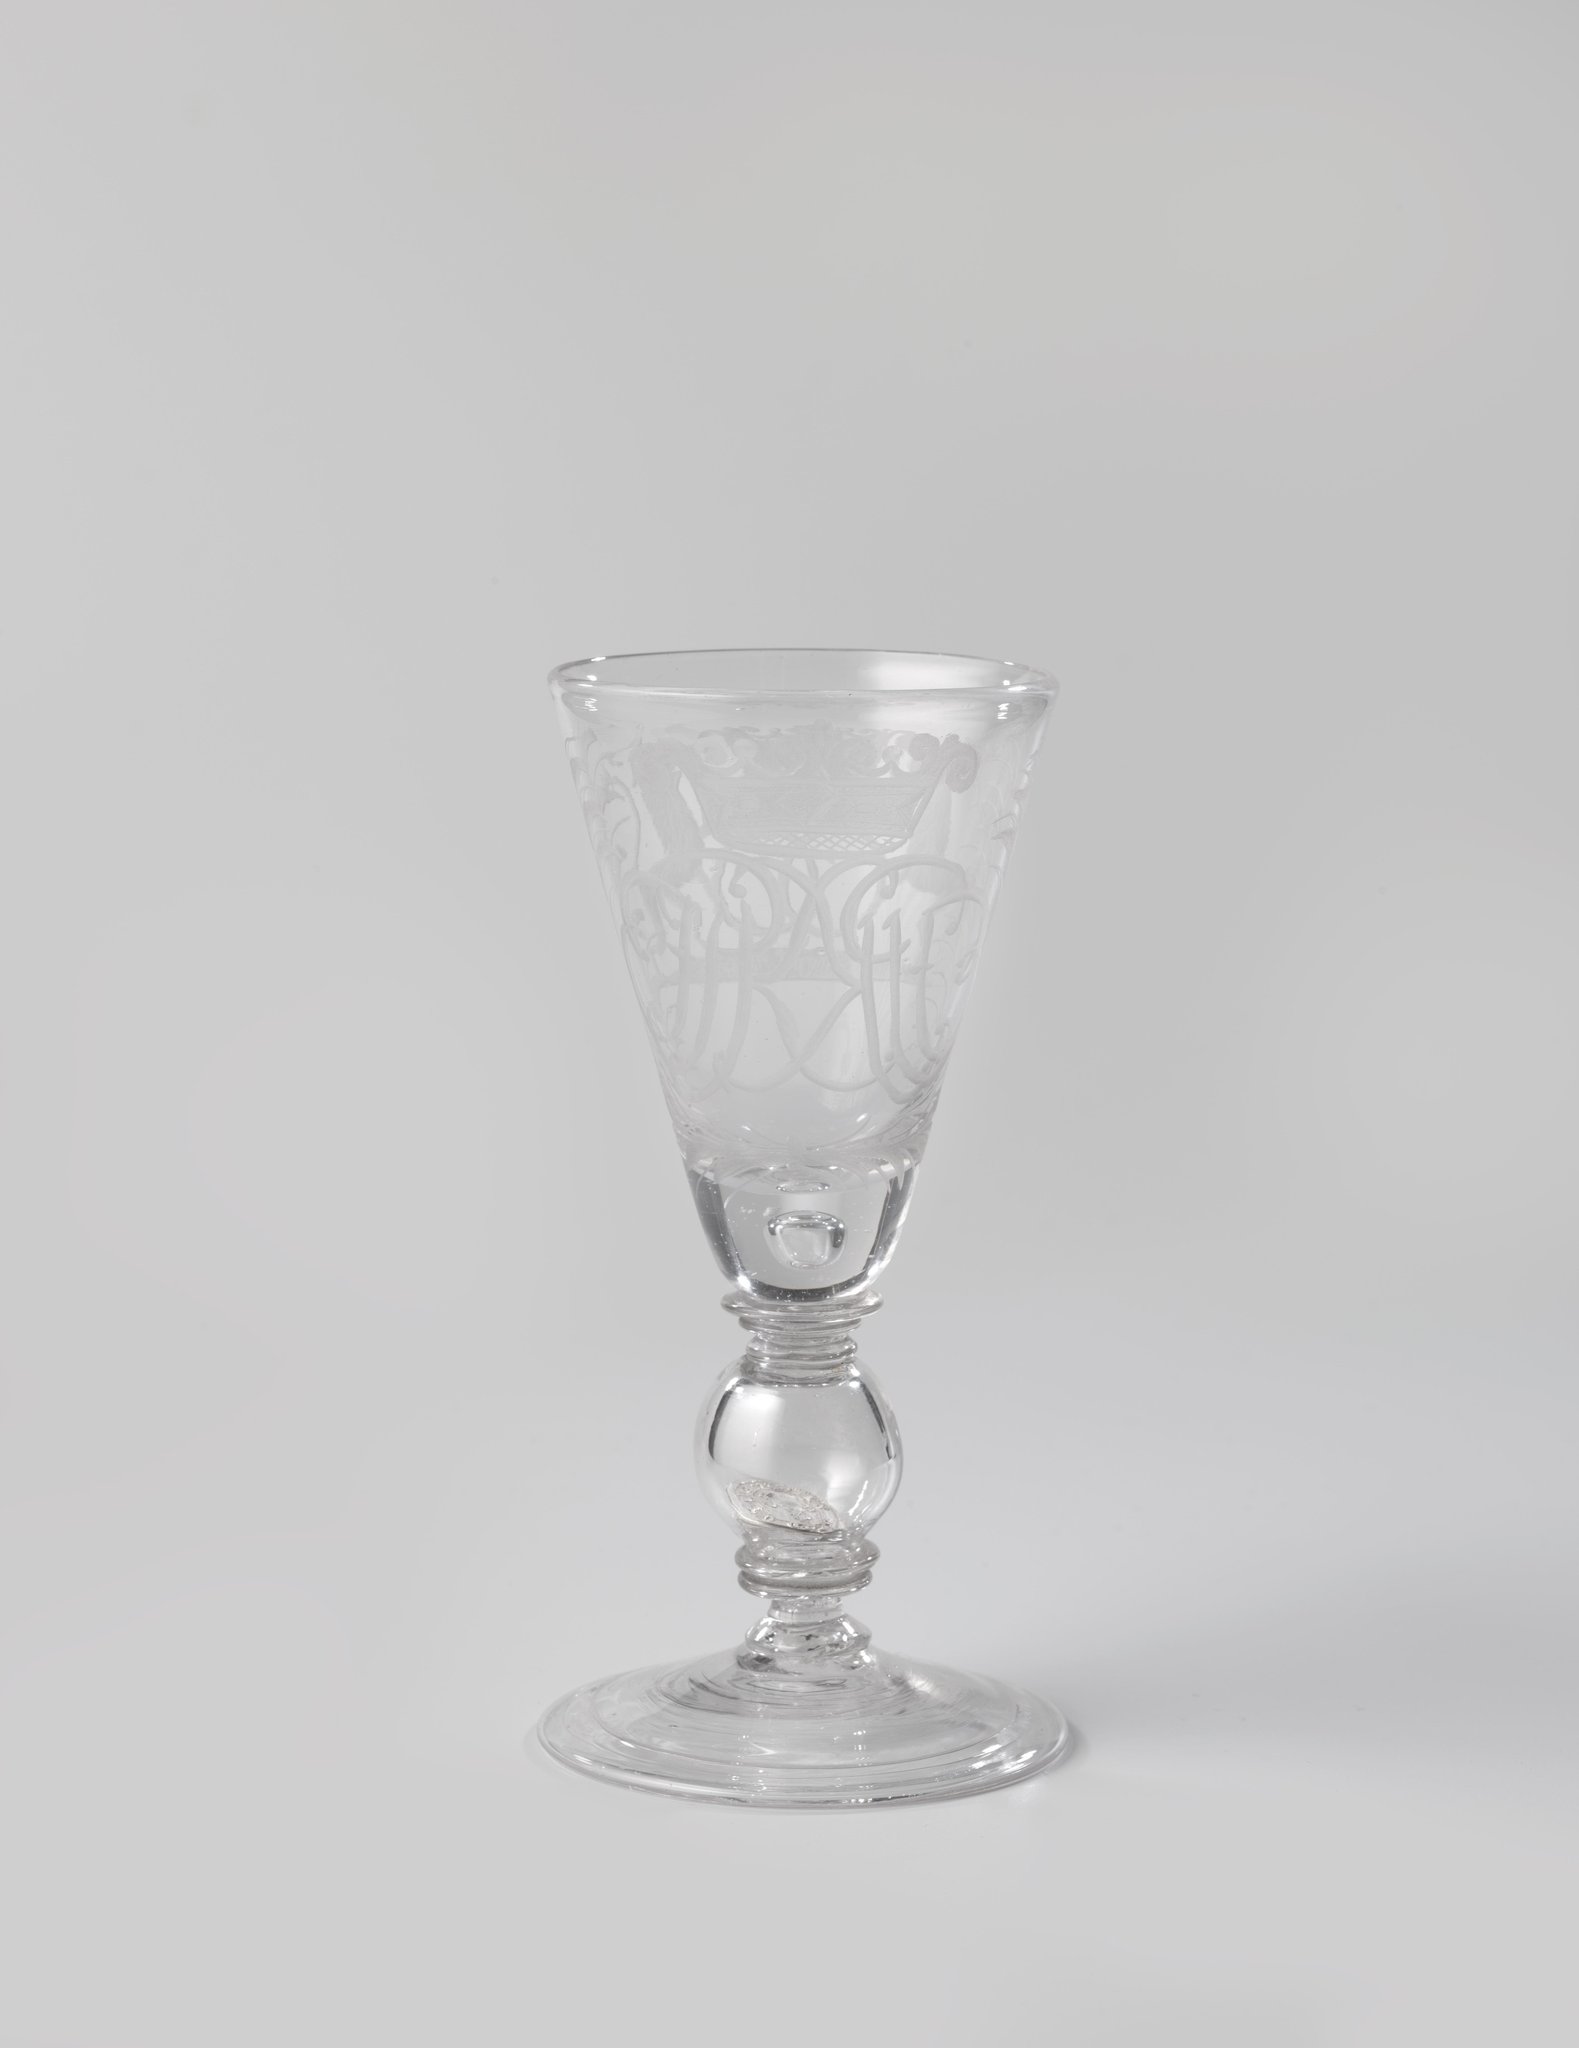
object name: goblet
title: Kelkglas met een ingesloten munt (twee mariëngroschen) en monogram RGB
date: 1714-1725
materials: glass, silver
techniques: glassblowing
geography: northern netherlands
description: Conische voet met omgeslagen rand. De stam samengesteld uit een holle knoop tussen twee samengestelde platte knopen. In de knoop is een zilveren munt (twee mariëngroschen) van George Lodewijk van Brunswijk-Lüneburg (1660-1727), gedateerd 1714, opgenomen. De trechtervormige kelk met verdikte bodem en luchtblaasjes. Op de kelk het gekroonde monogram RGB geflankeerd door twee lauriertakken bijeengebonden aan de onderzijde. Op de andere zijde, op een grondje met gras, steunen twee leeuwen een kroon met een voorpoot en met de andere een dubbelkoppige, opgerolde slang.